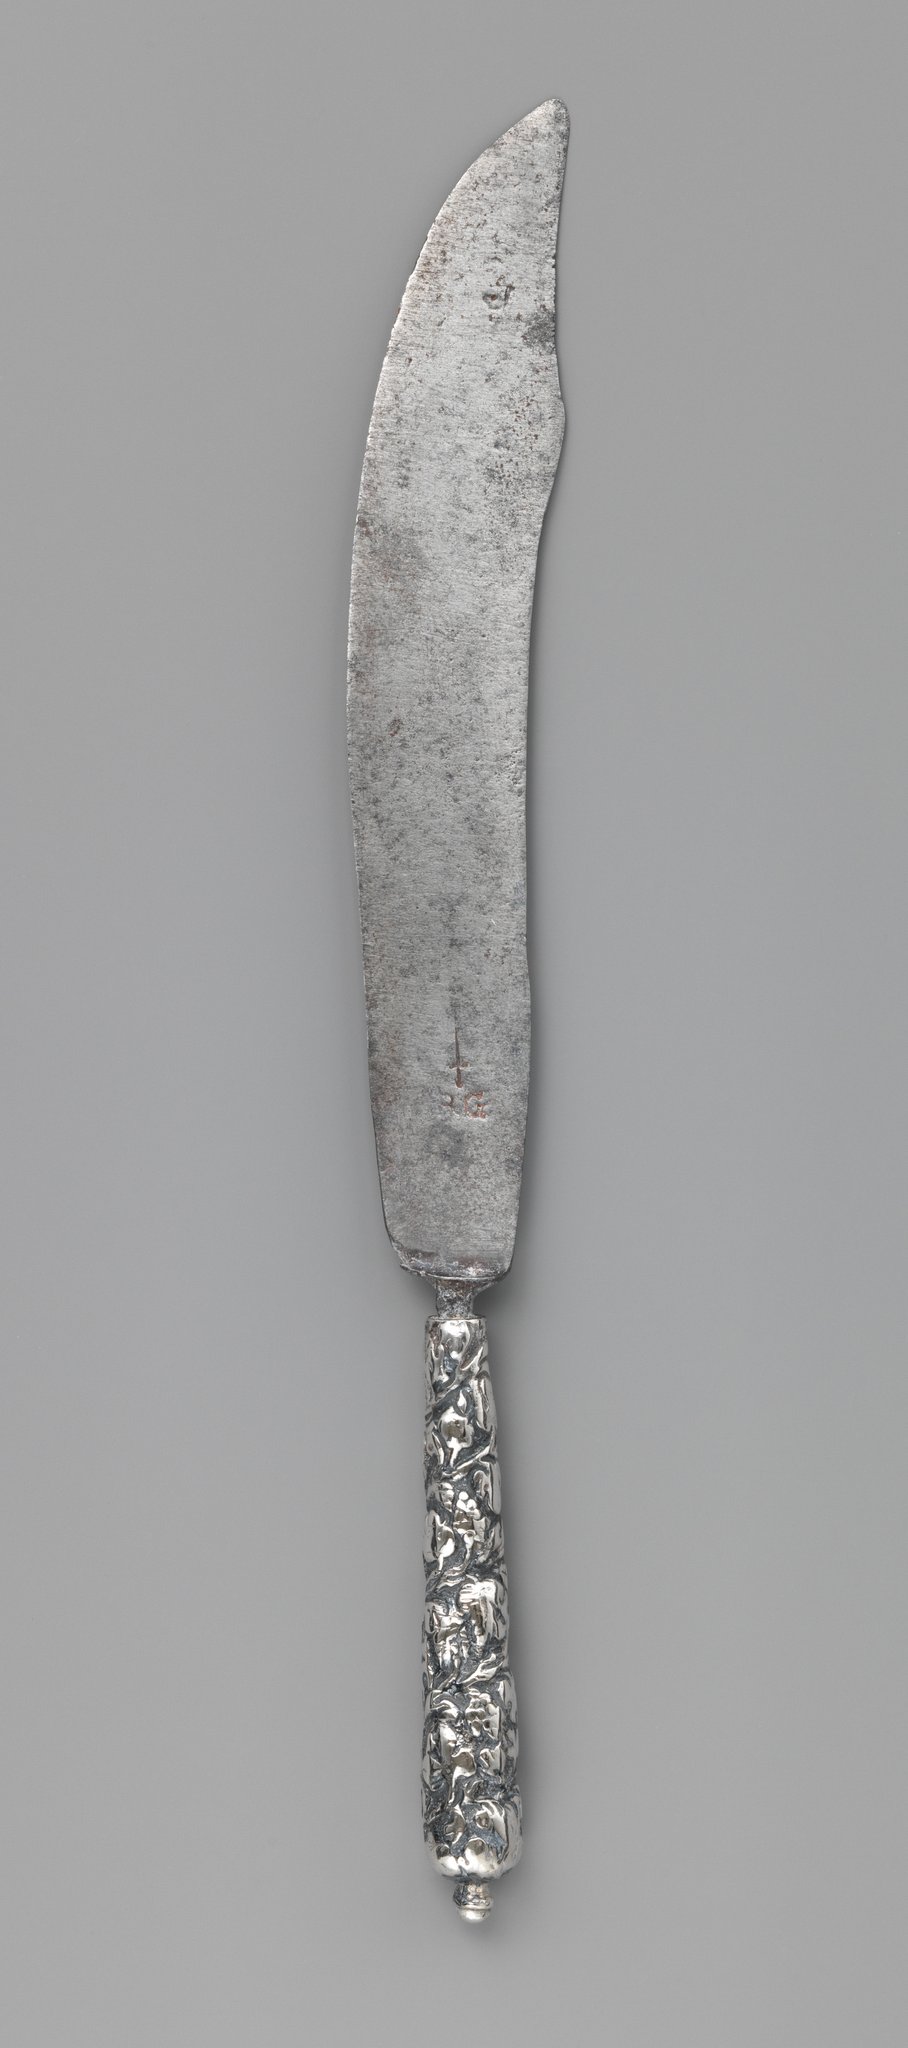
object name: knife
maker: rg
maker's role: maker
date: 1501-1700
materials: silver, steel